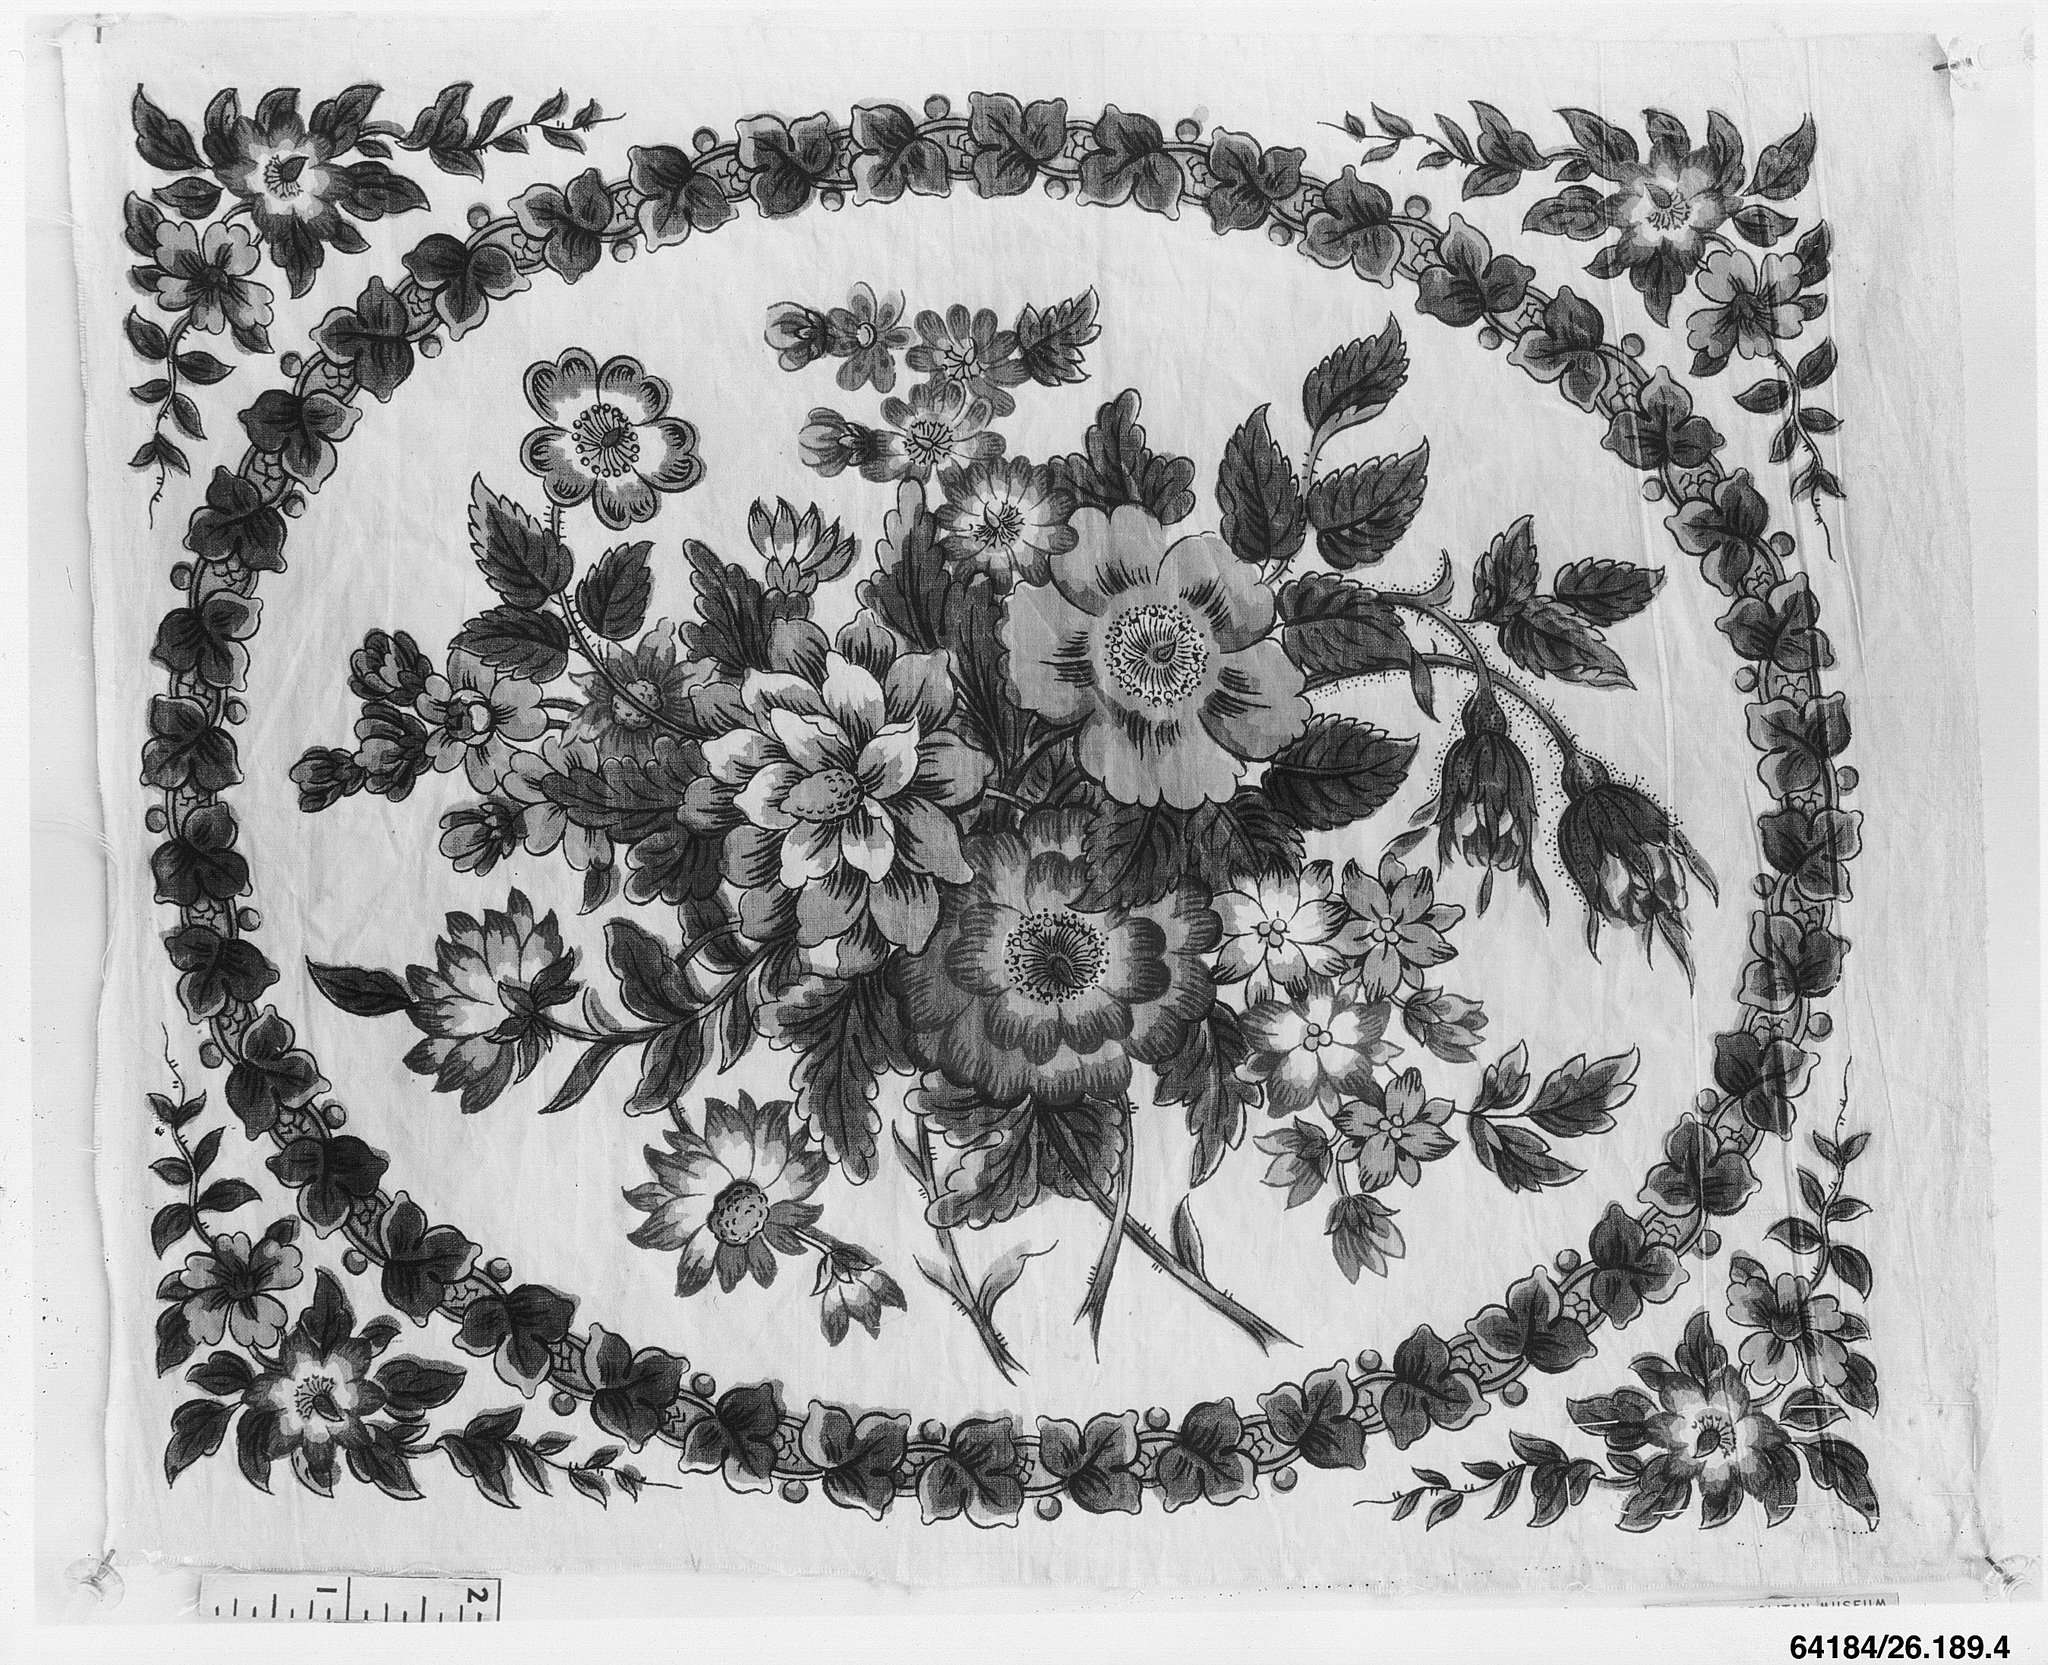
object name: panel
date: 1815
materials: cotton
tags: flowers,leaves